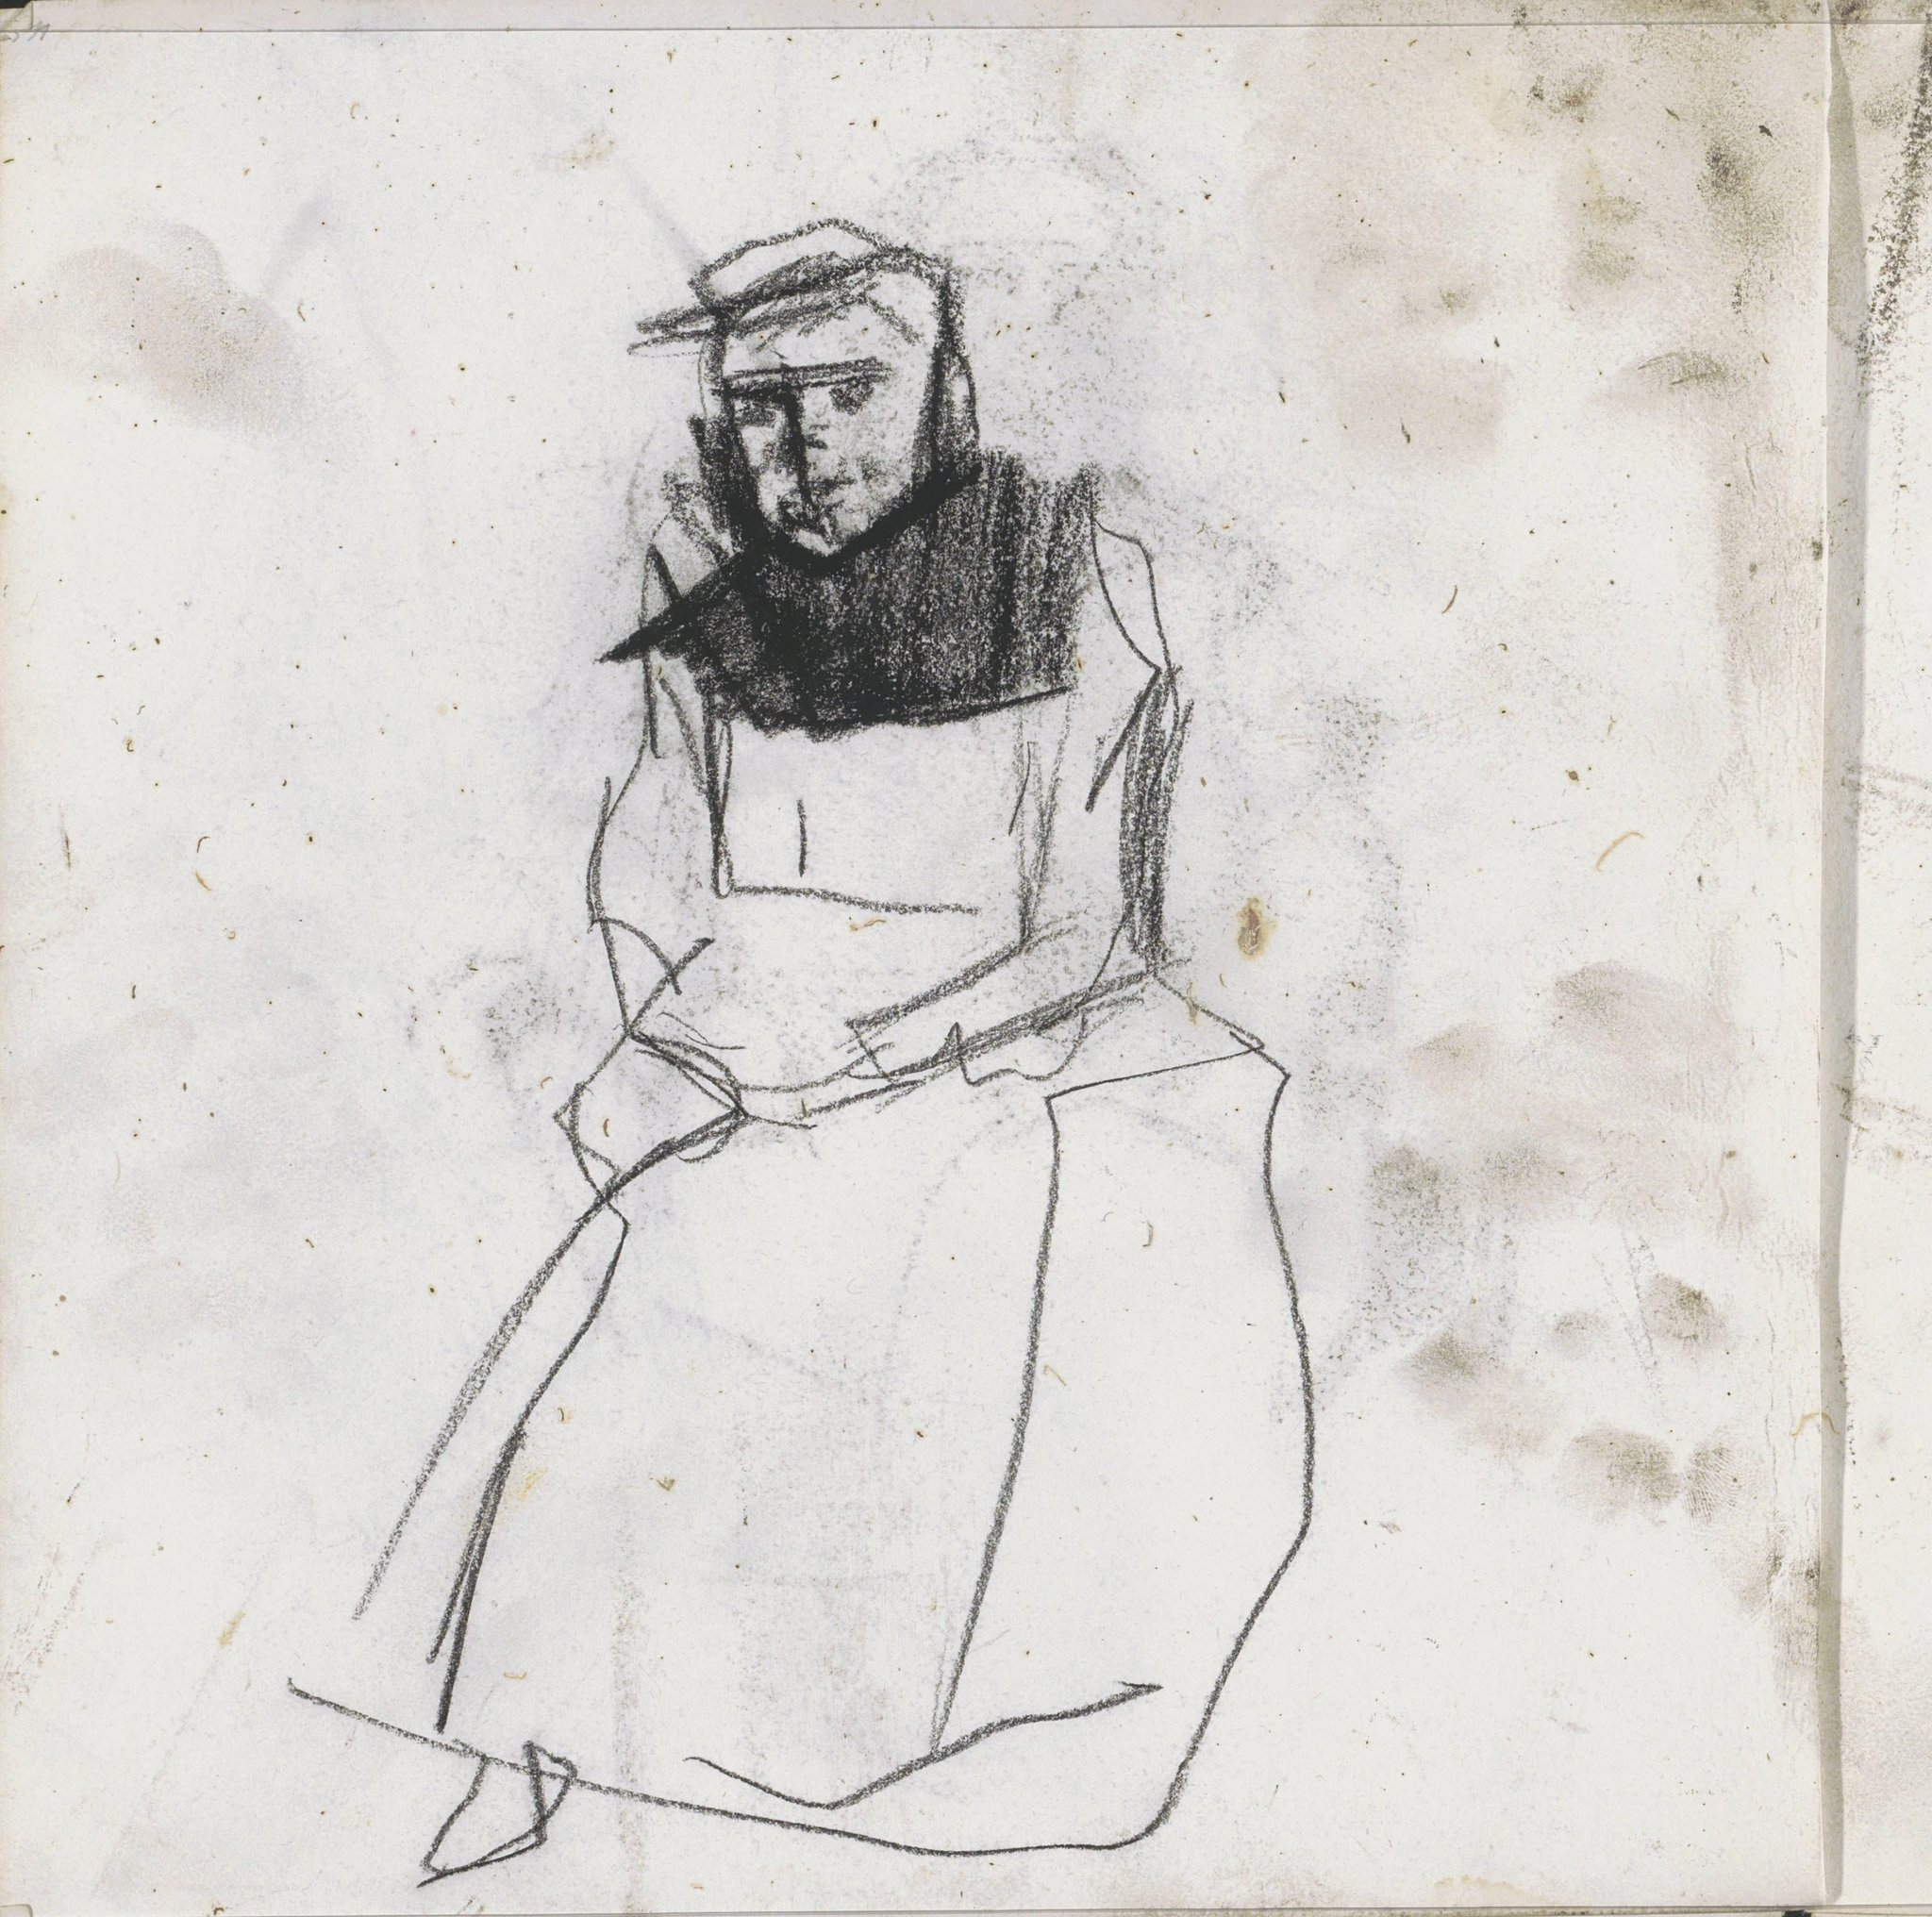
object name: sketchbook leaf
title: Zittende vrouw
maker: isaac israels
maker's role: draughtsman, painter, print maker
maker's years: 1865-1934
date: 1875-1934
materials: chalk, paper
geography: the hague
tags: adult woman (+ sitting)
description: Blad 12 verso uit schetsboek IX met 28 bladen.